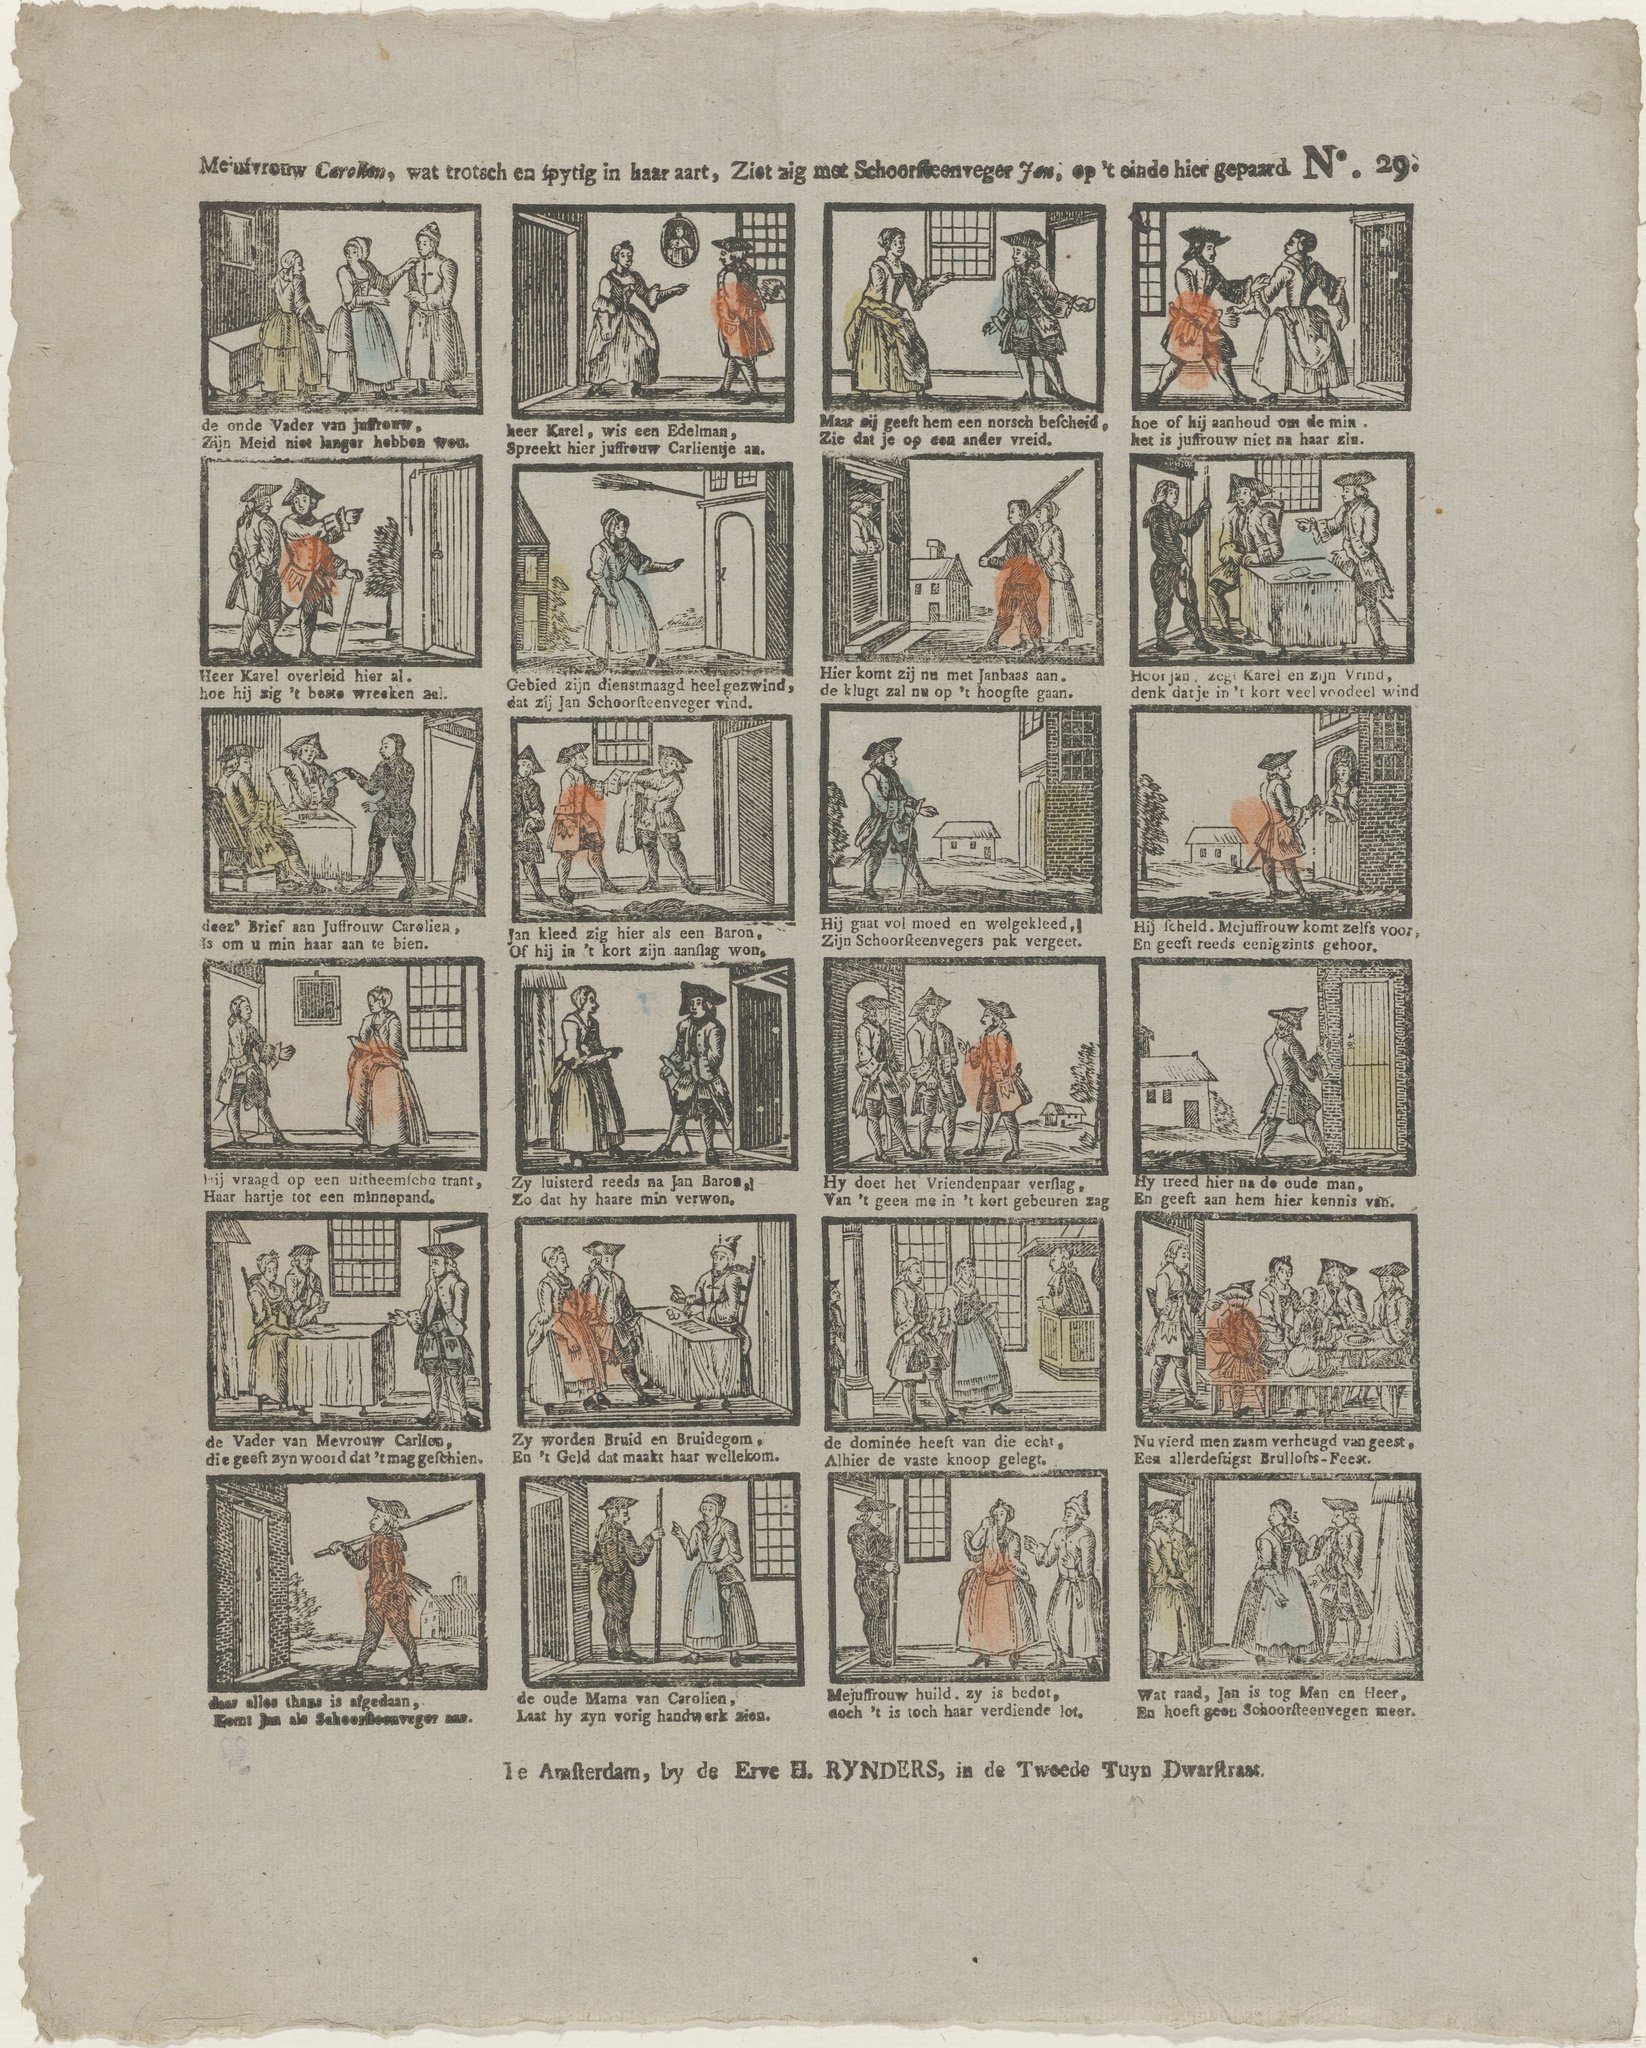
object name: print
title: Mejufvrouw Carolien, wat trotsch en spytig in haar aart, Ziet zig met schoorsteenveger Jan, op 't einde hier gepaard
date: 1831-1854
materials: paper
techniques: colour, letterpress printing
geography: amsterdam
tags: handicrafts ~ maintenance and repair (with name of trade or profession), betrothal and marriage, marriage contract, nobility and patriciate; chivalry, knighthood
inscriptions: collector's mark: Lugt 2760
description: Blad met 24 voorstellingen uit het verhaal van Carolien en schoorsteenveger Jan. Twee afgewezen minnaars van de hoogmoedige Carolien sturen haar een schoorsteenveger die zij rijk hebben uitgedost en goed van geld voorzien. Carolien wordt verliefd en trouwt de vermeende edelman, die daags na het huwelijk zich voordoet voor wat hij werkelijk is. Onder elke afbeelding een tweeregelig vers. Genummerd rechtsboven: No. 29.